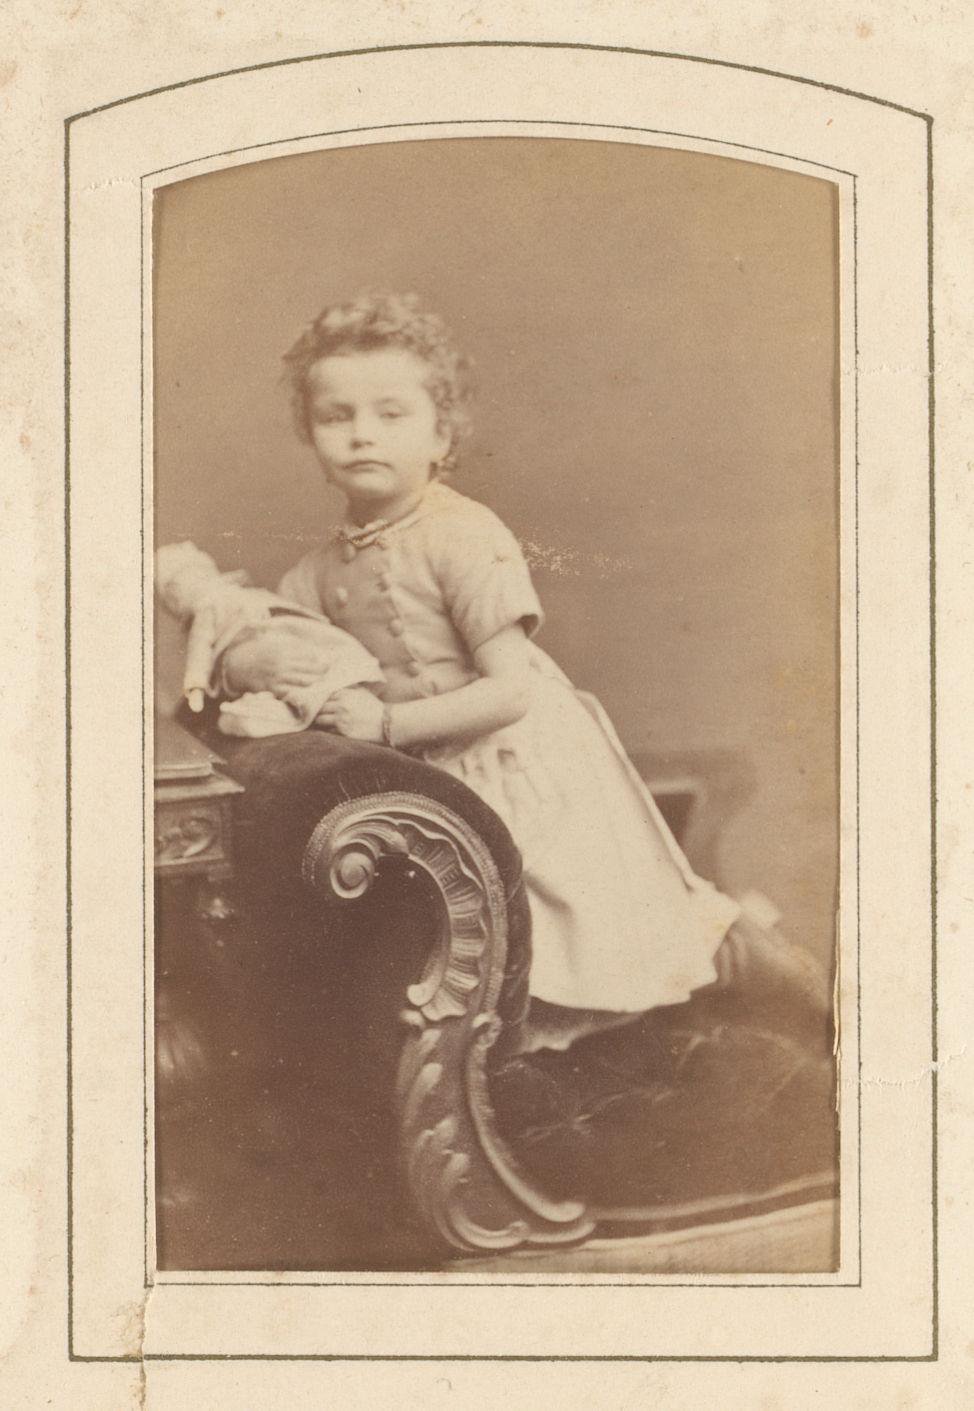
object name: photograph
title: Portret van een meisje met pop in de hand, op knieën zittend op een stoel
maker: albert greiner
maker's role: fotograaf, fotostudio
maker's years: 1833-1890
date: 1861-1887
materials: cardboard, photographic support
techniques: albumen print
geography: amsterdam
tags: historical persons - bb - woman, (playing with) dolls, toddler (female), chair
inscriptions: inscription: ‘A. GREINER/ Photograf/ AMSTERDAM/ NIEUWENDIJK L. 89’